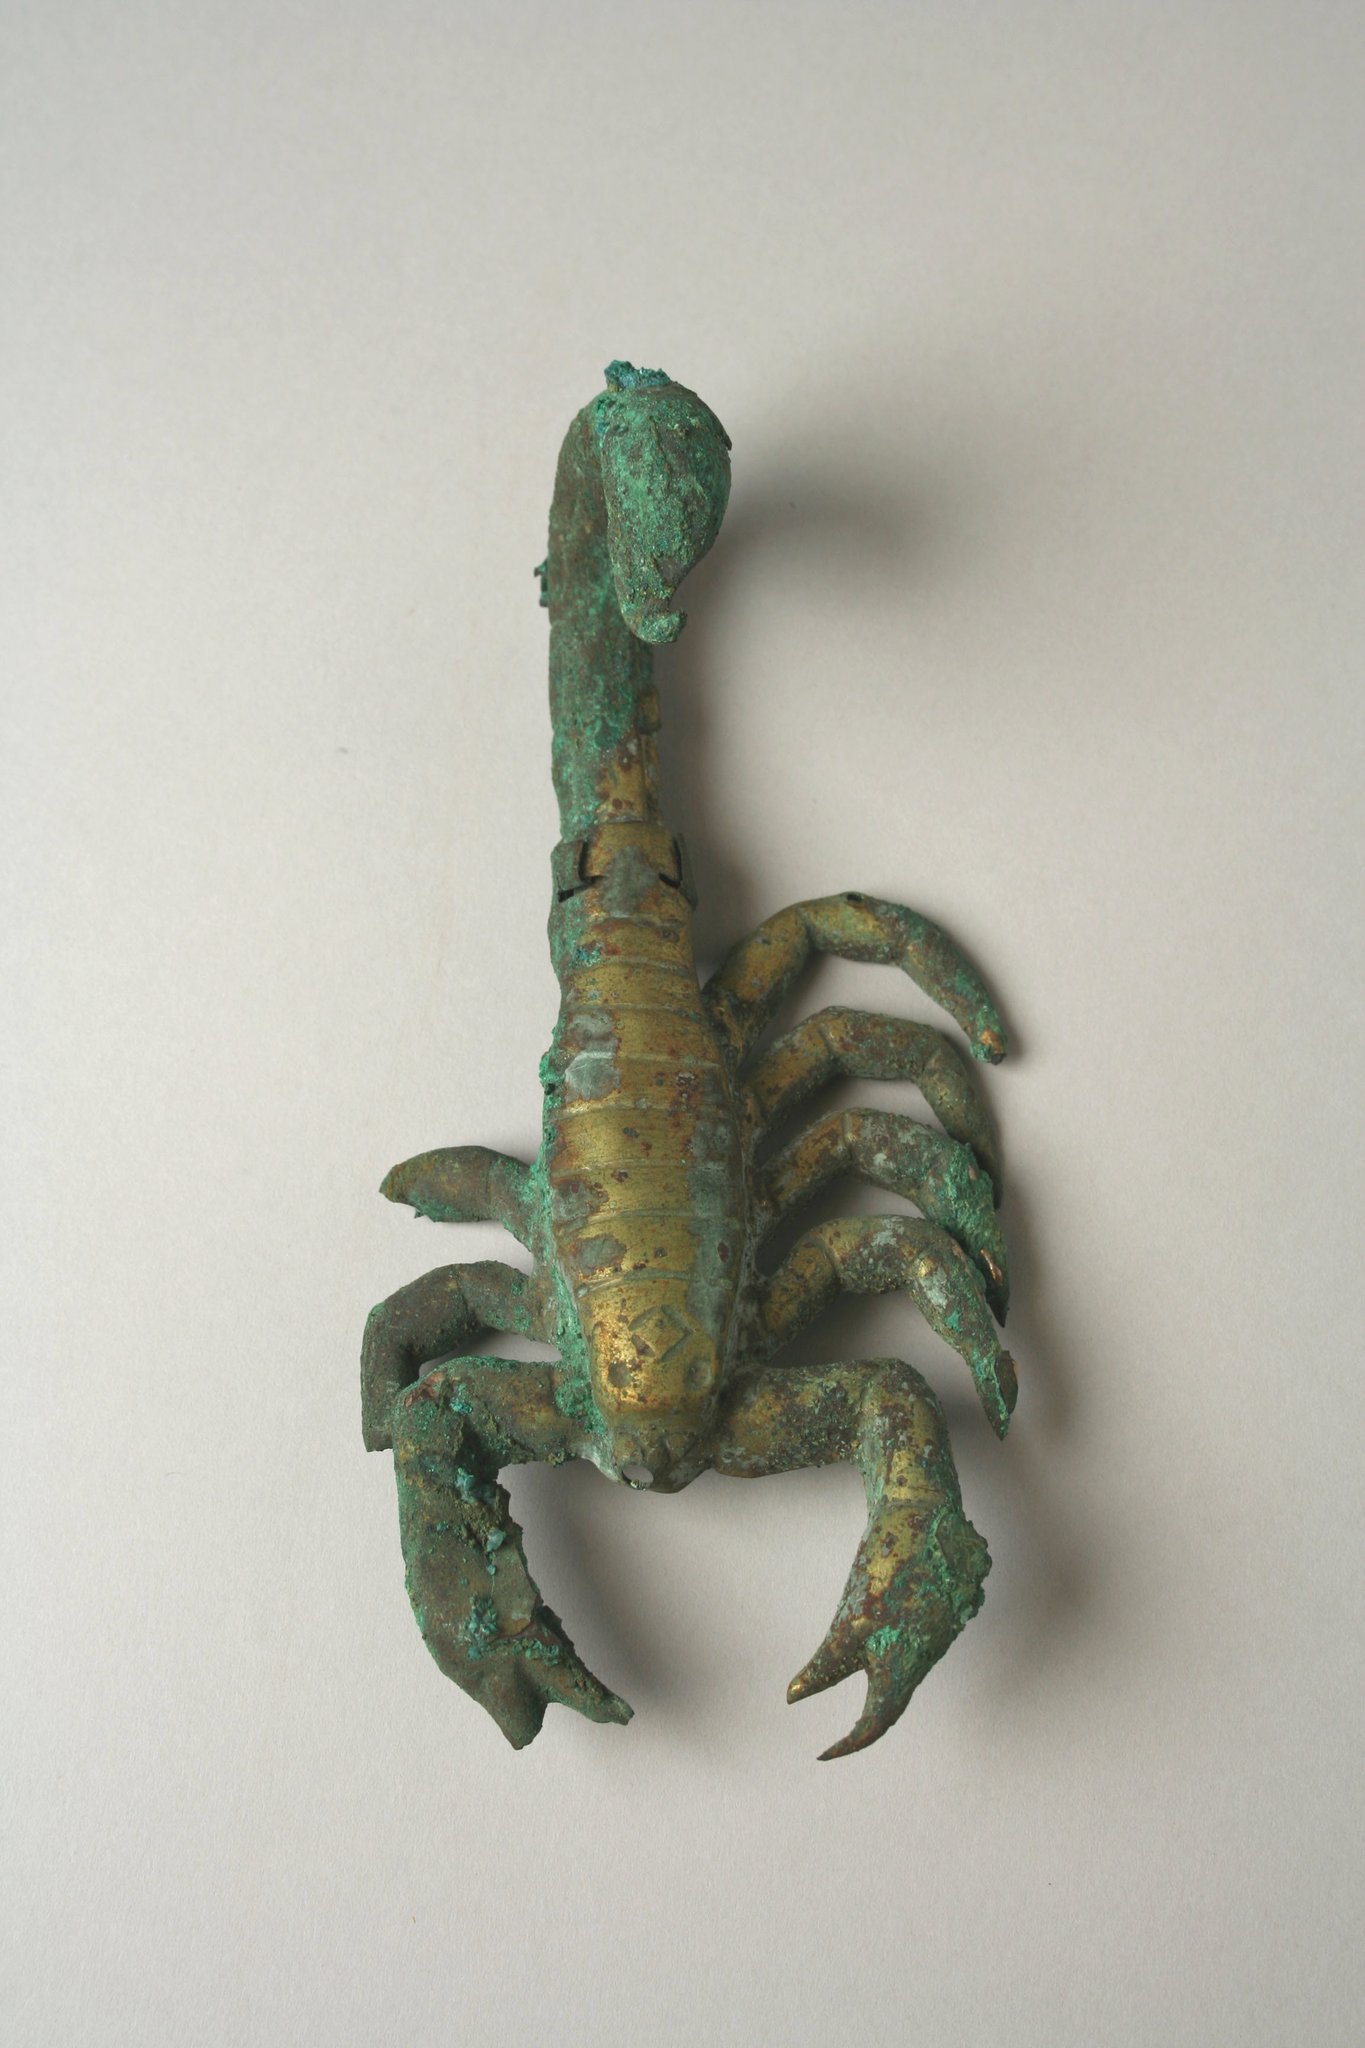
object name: ornament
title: Scorpion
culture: moche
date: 501-700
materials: gilt copper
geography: peru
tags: scorpions